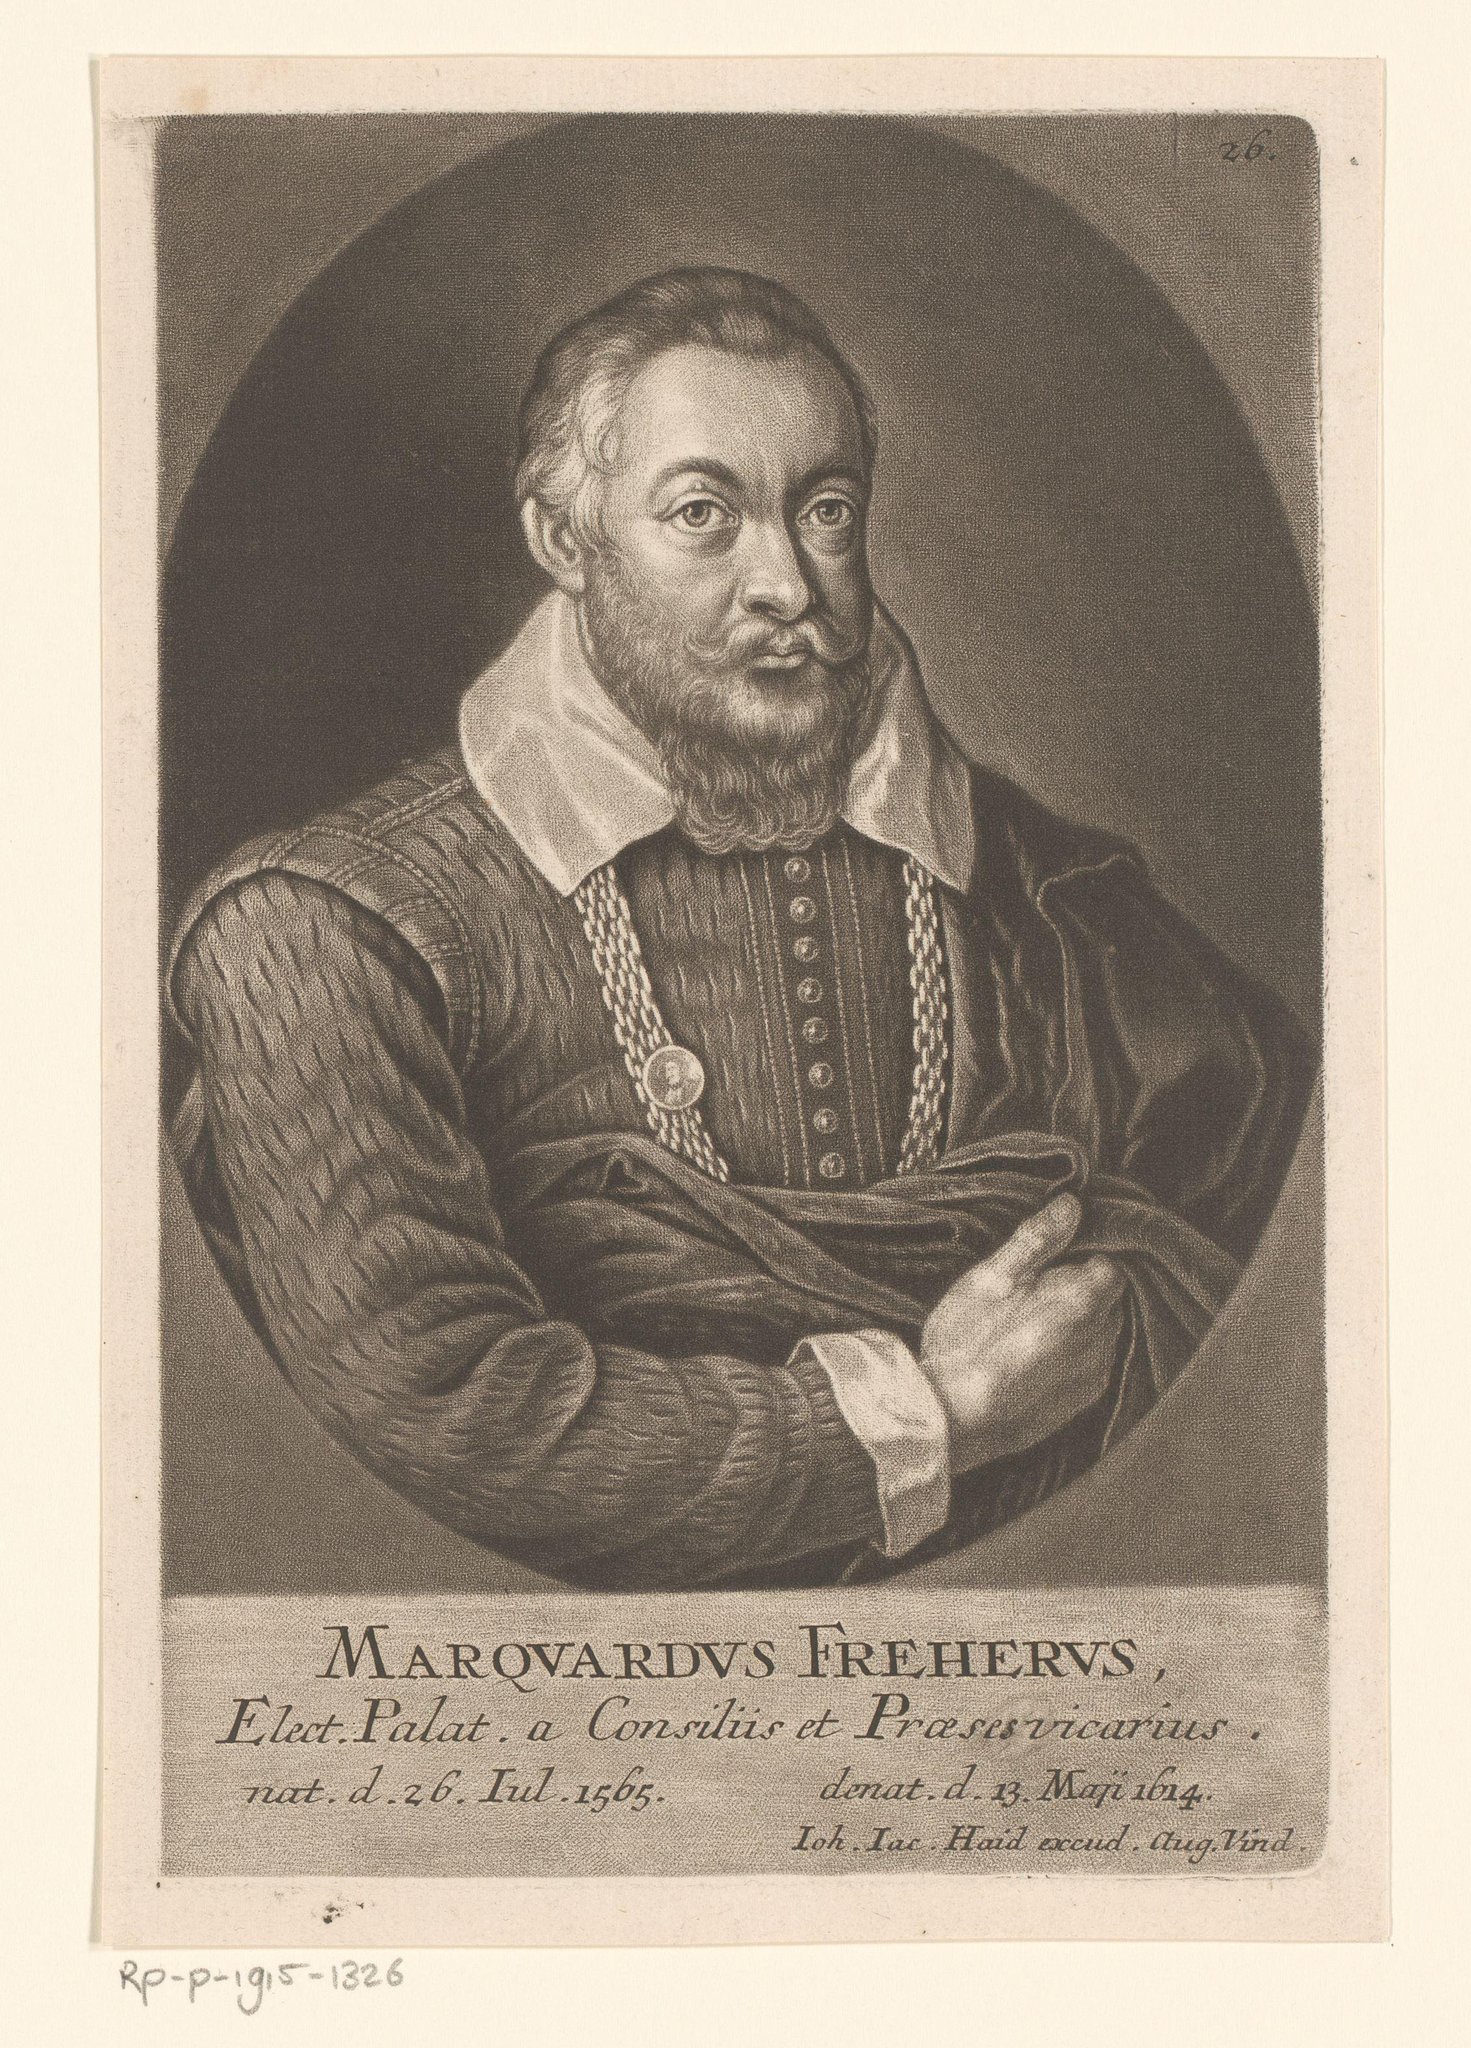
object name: print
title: Portret van Marquard Freher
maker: johann jacob haid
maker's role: print maker, publisher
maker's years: 1704-1767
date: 1747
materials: paper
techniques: mezzotint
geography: augsburg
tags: historical persons, pendant, trinket, 'breloque'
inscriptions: collector's mark: Lugt 2228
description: Prent gebruikt voor: Brucker, Jacob. Ehrentempel der Deutschen Gelehrsamkeit. Augsburg: Johann Jacob Haid, 1747.